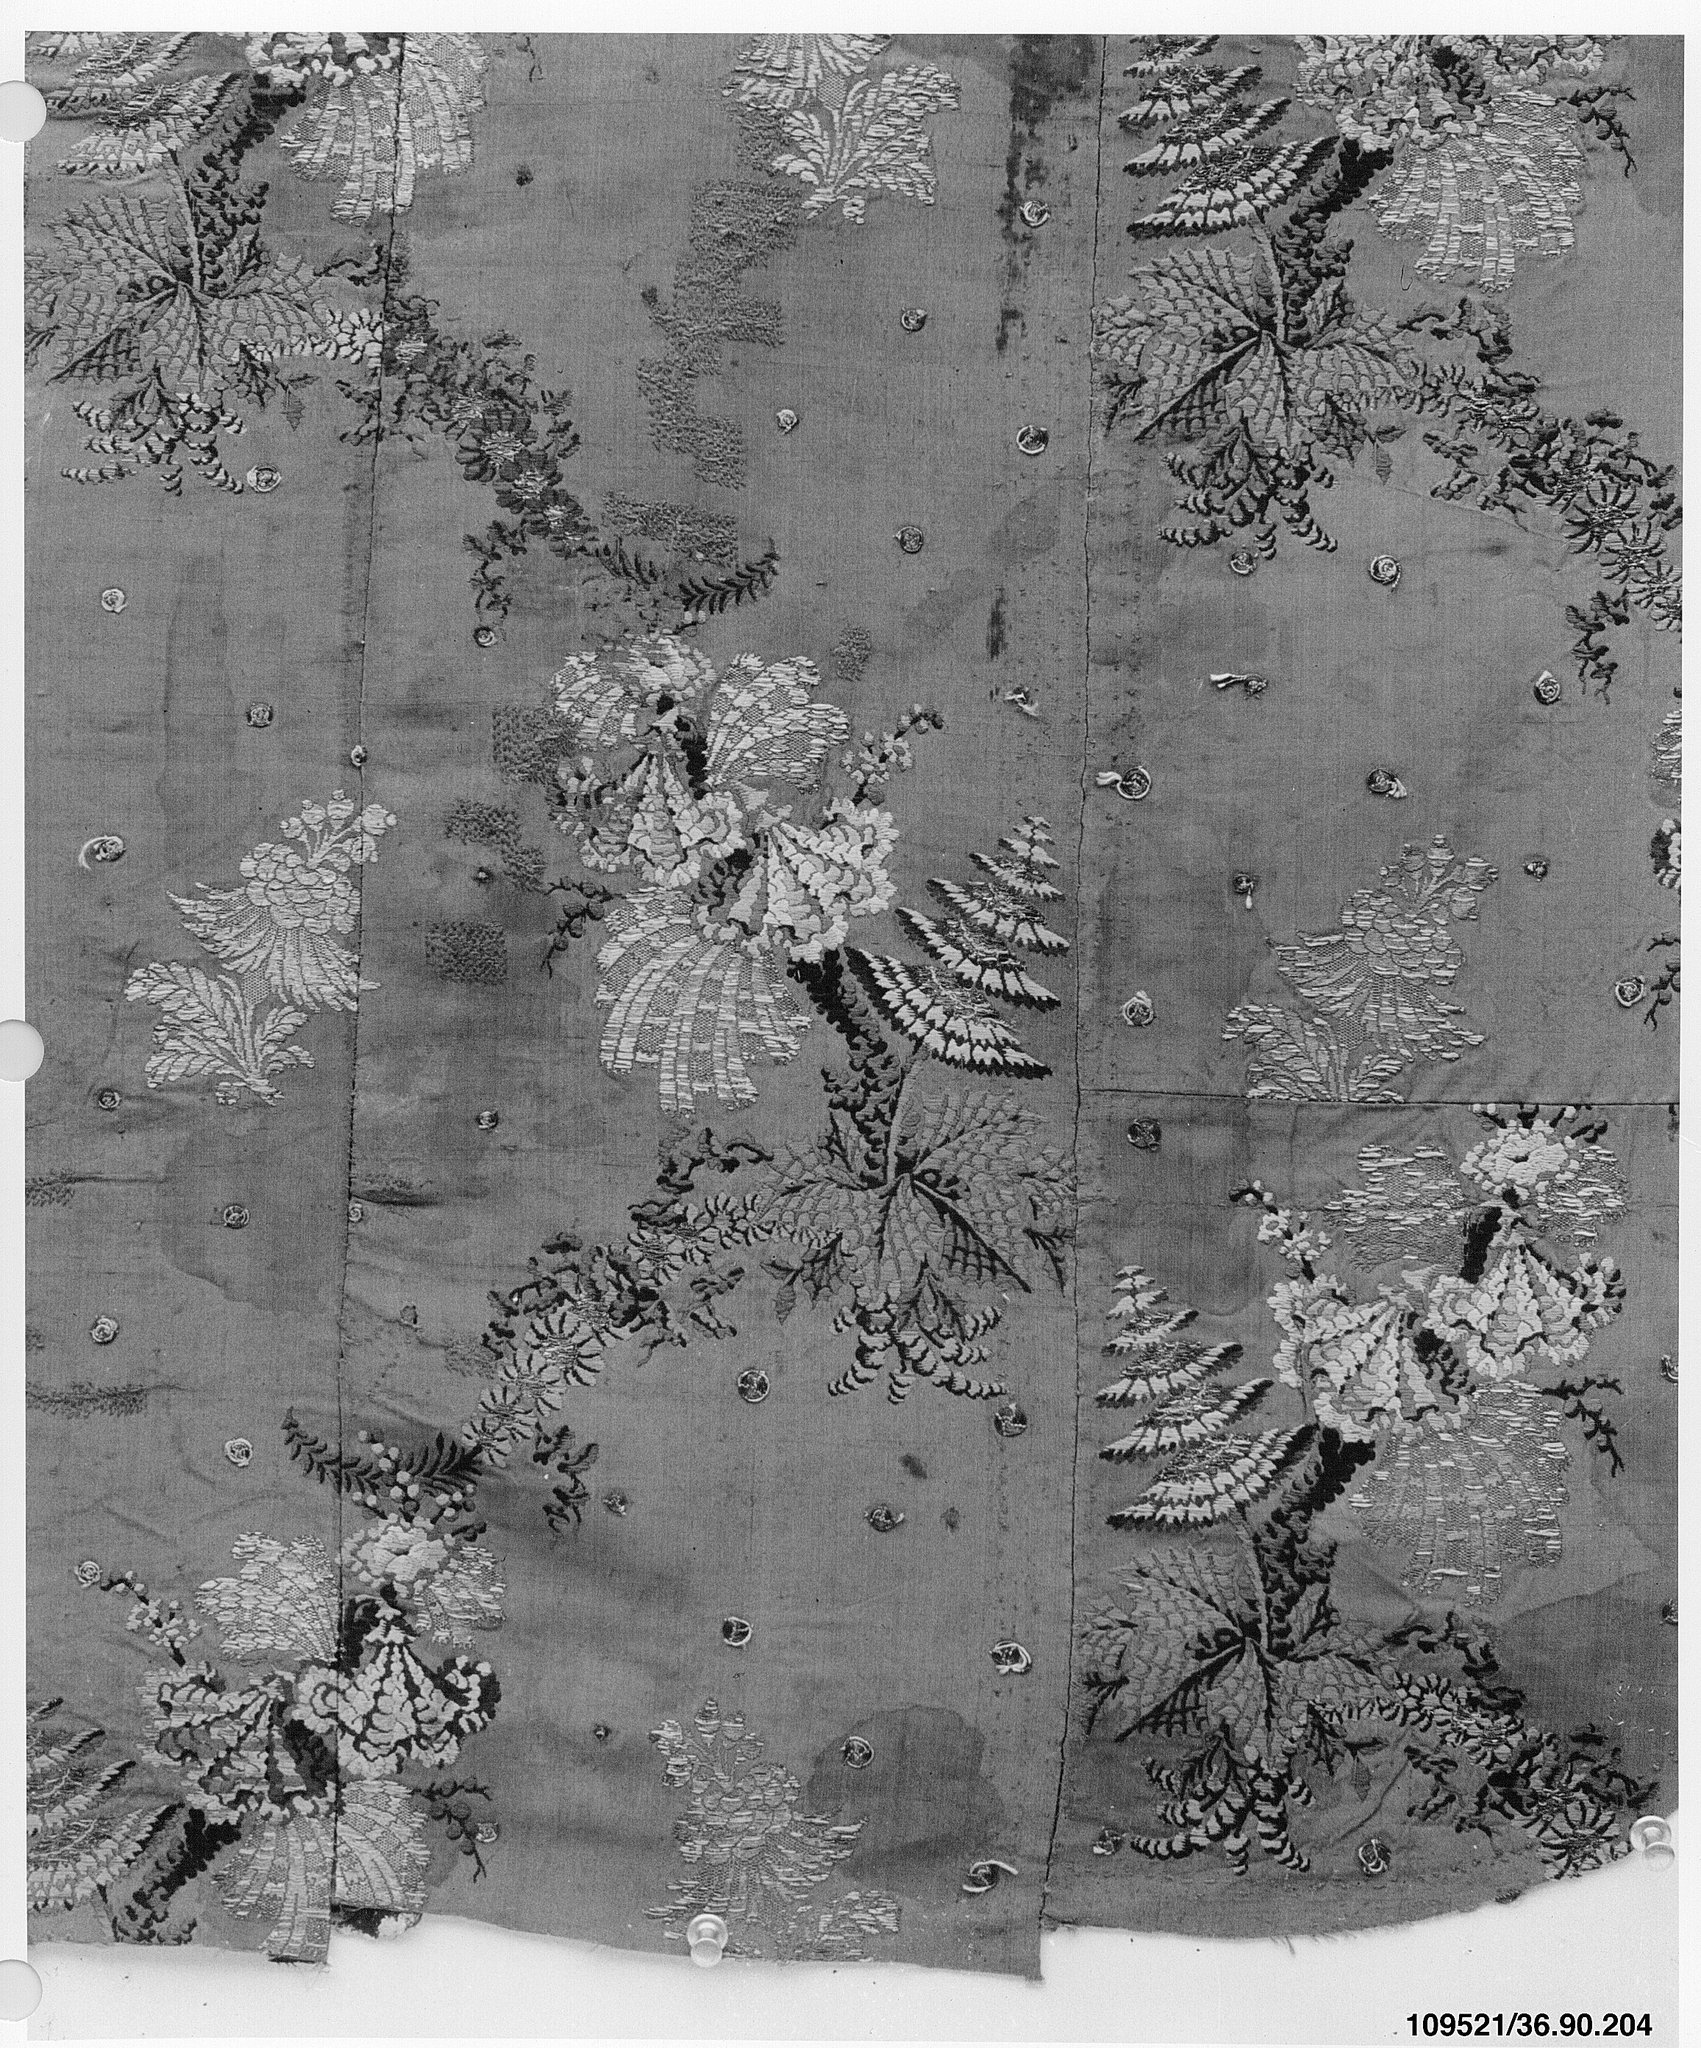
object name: piece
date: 1760-1770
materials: metal thread, silk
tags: flowers,leaves